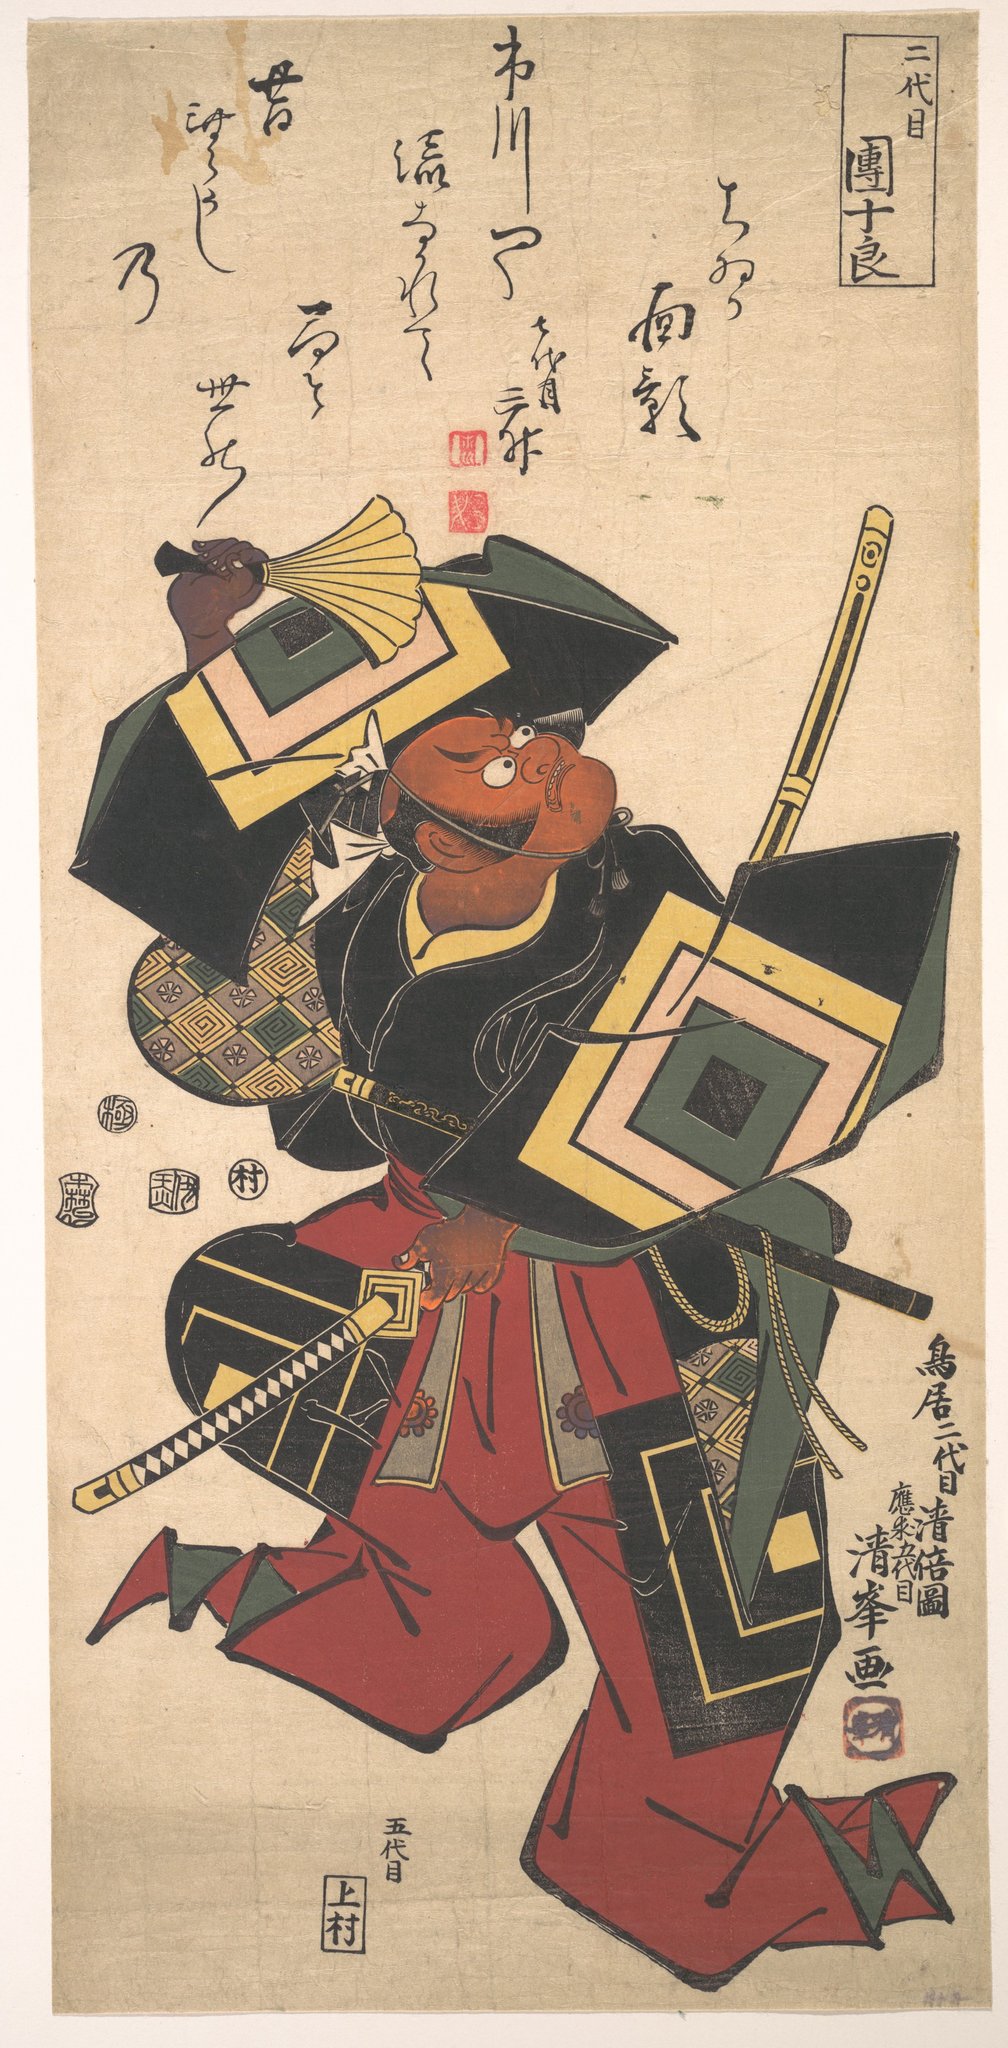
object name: print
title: The Actor Ichikawa Danjuro II, 1688–1758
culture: japanese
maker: torii kiyomine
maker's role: artist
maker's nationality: japanese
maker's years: 1787-1868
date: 1804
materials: ink, paper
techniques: woodblock print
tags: theatre,men,actors